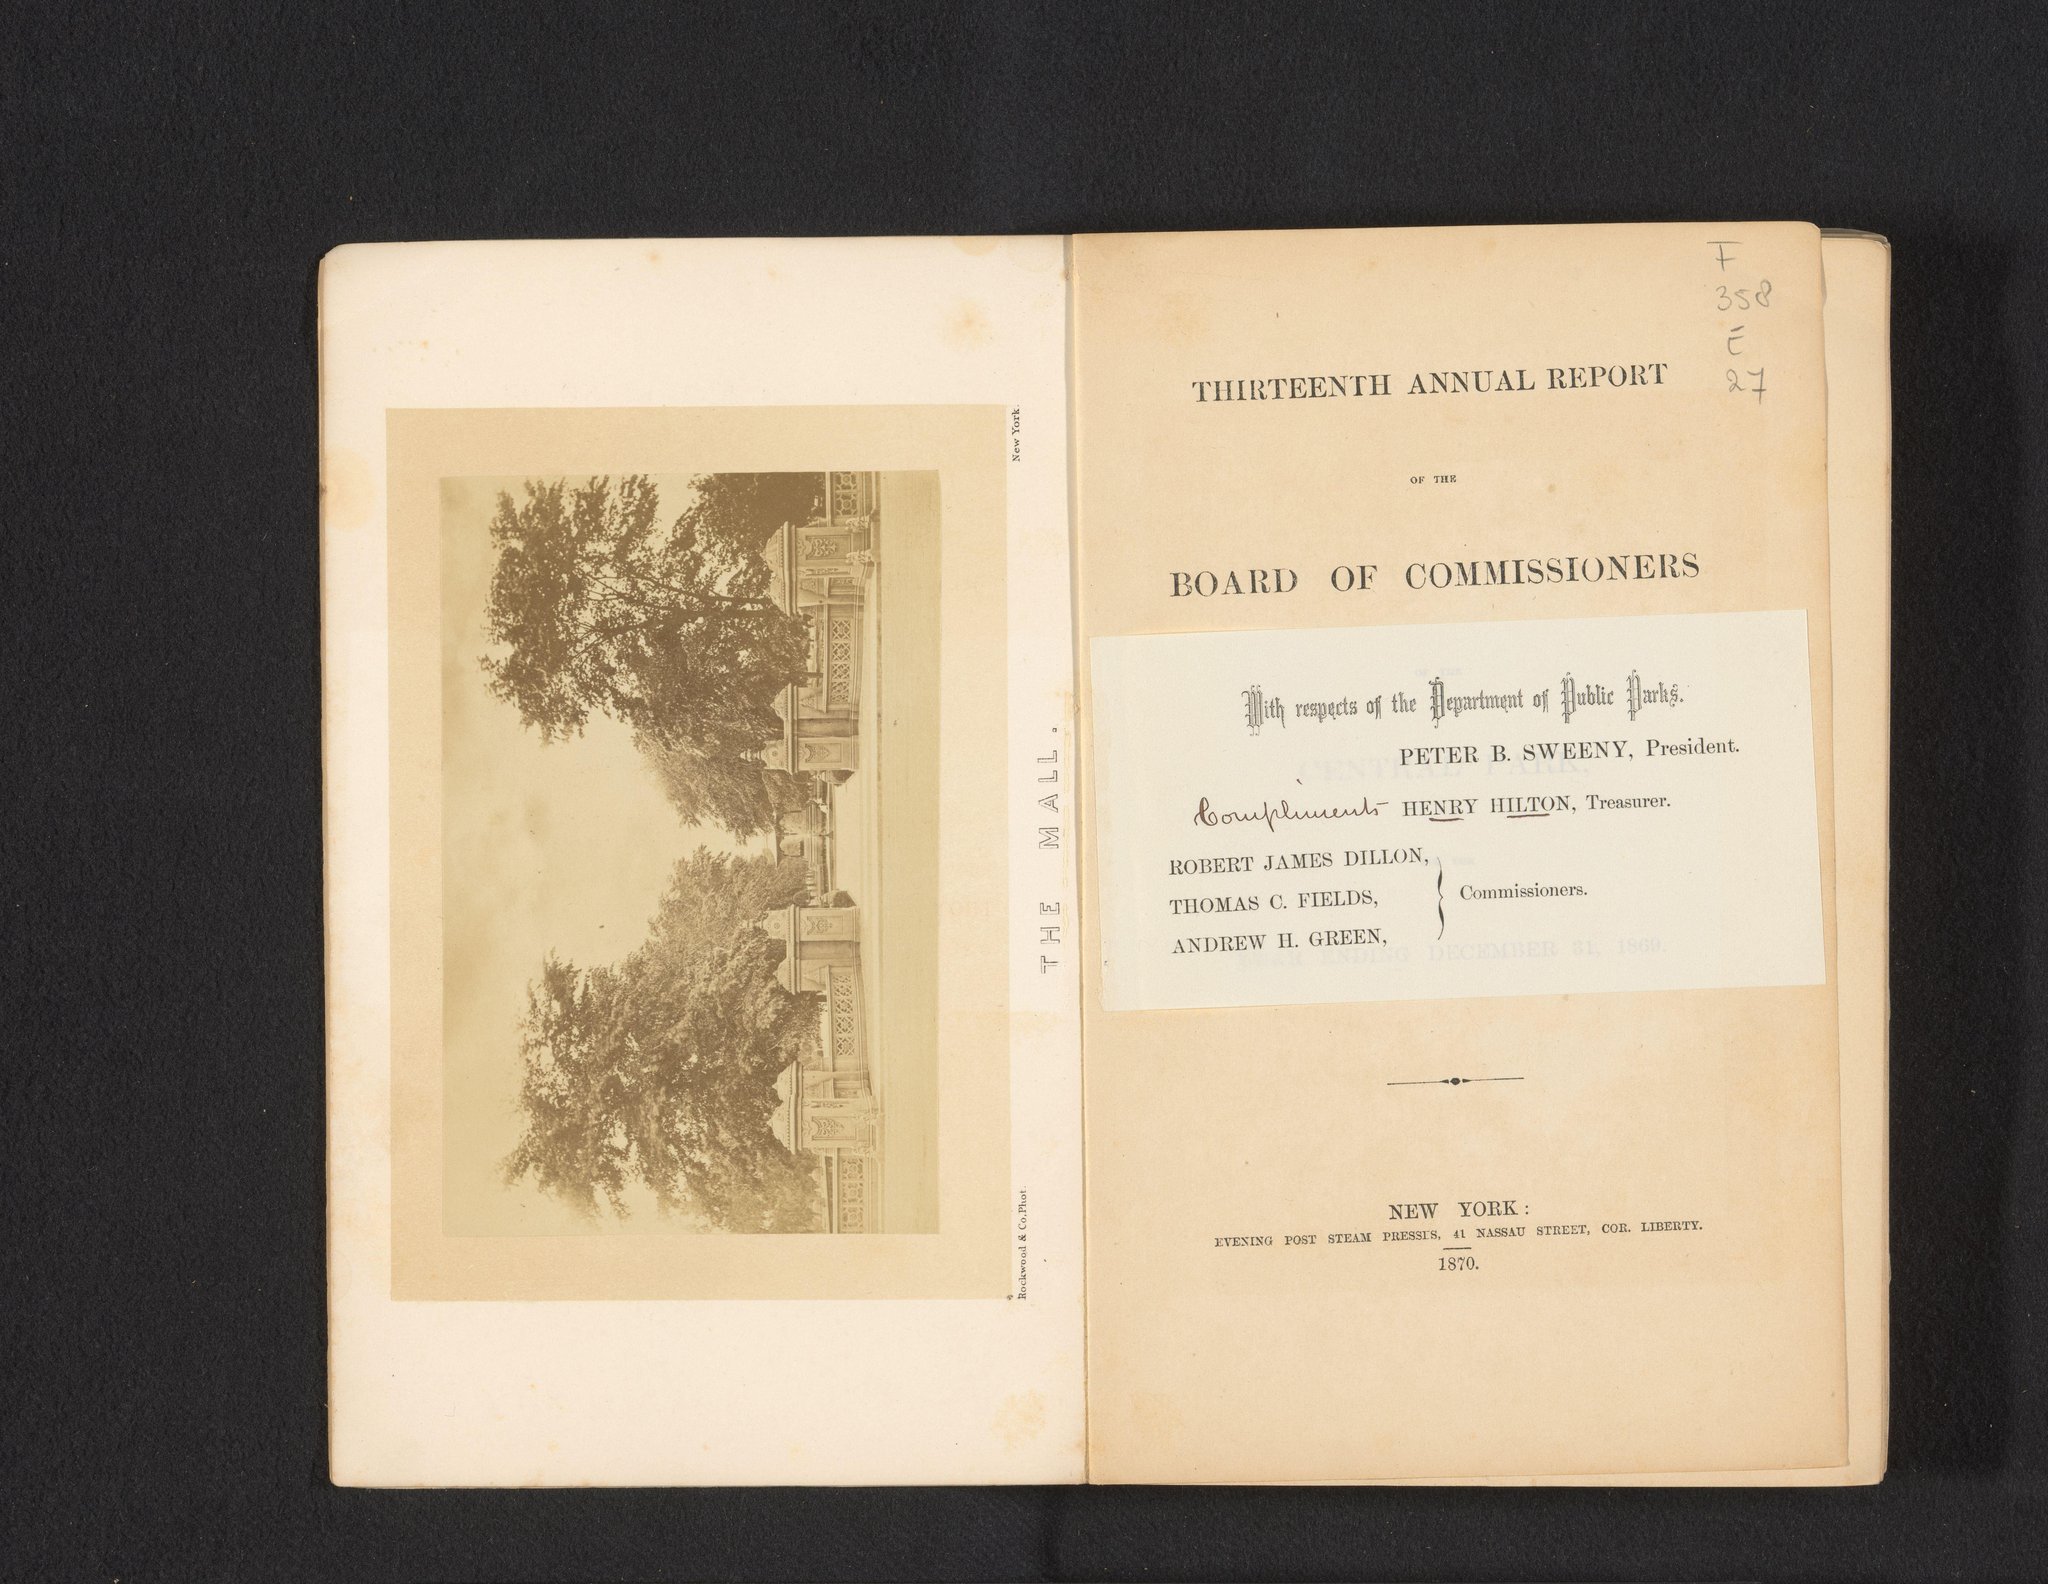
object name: page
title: The Mall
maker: george gardner rockwood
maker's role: fotograaf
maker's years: 1832-1911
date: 1869-1870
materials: photographic support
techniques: albumen print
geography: central park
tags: avenue, boulevard, promenade, esplanade, public gardens, park